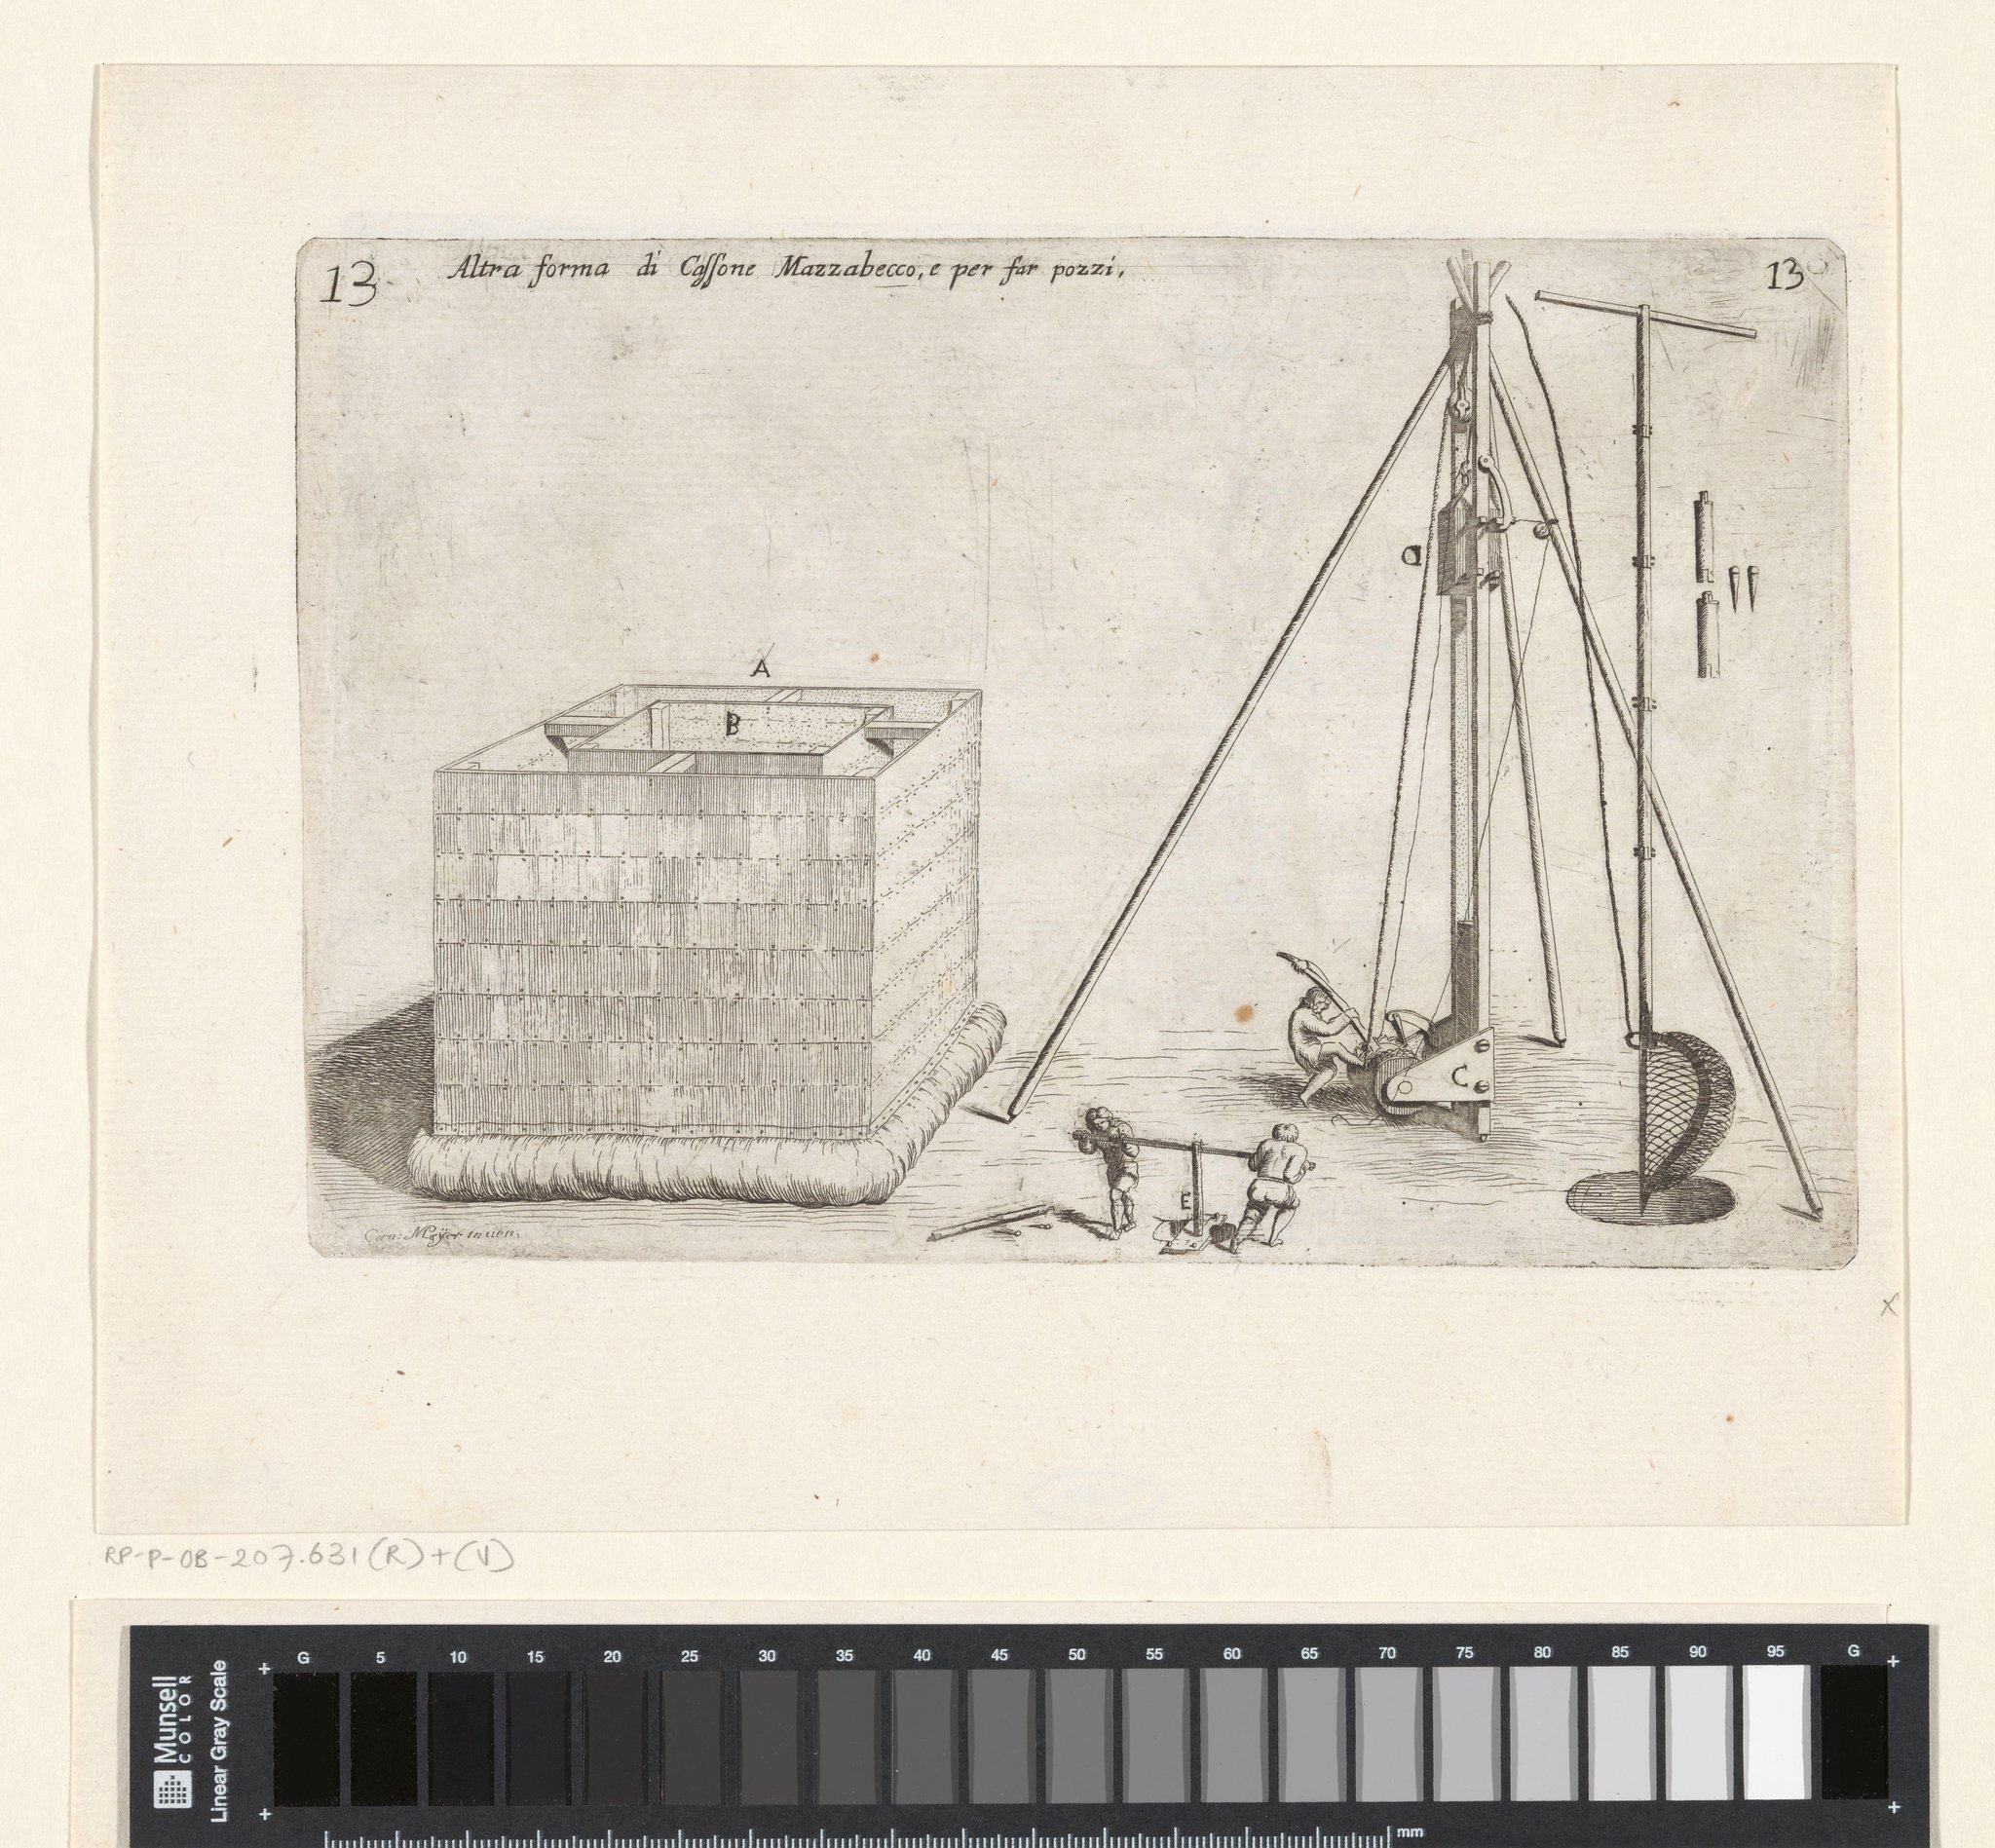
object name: print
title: Werklieden, een grote kist en gereedschap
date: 1677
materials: paper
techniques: etching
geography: italy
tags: tools, aids, implements ~ crafts and industries, working class, labourers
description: Deze prent maakte oorspronkelijk deel uit van een publicatie bestaande uit drie delen, uitgegeven door G.G. Komarek in Rome in 1696. Het eerste deel zit achter een titelpagina met de titel: L'arte di rendere i fiumi navigabili, in varij modi, con altre nuove inventioni, e varij altri segreti. Deel twee zit achter een titelpagina met de titel: Racolta di varii segreti come si vedono nelle segventi figure. Deel drie zit achter een titelpagina met de titel: Osservazioni delle comete che dovranno seguire, e dell'ecclisse del primo satellite di Giove, et altre propositioni prosicue da farsi per commodo & ornamento della città. Deze prent komt uit het eerste deel. Prenten in de publicatie zijn naar ontwerp van Cornelis Meijer gemaakt door verschillende prentmakers, onder wie G.B. Falda, G. van Wittel, Gomar Wouters, etc. Er is ook een eerdere versie bekend van deze publicatie, uitgegeven in Rome in 1683, met de titel: L'arte di restituire a Roma la tralasciata navigazione del suo Tevere.